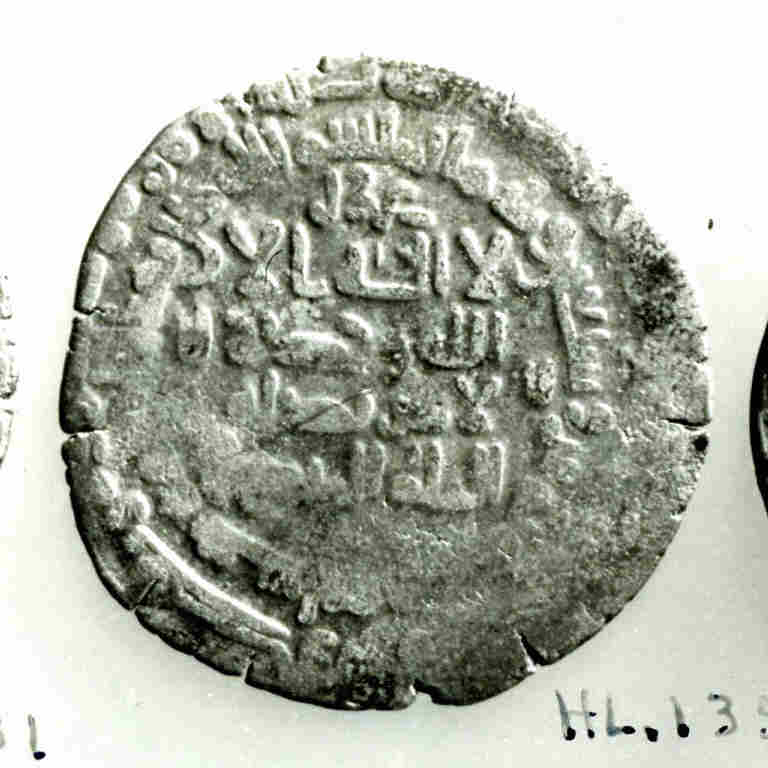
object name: coin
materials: silver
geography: iran